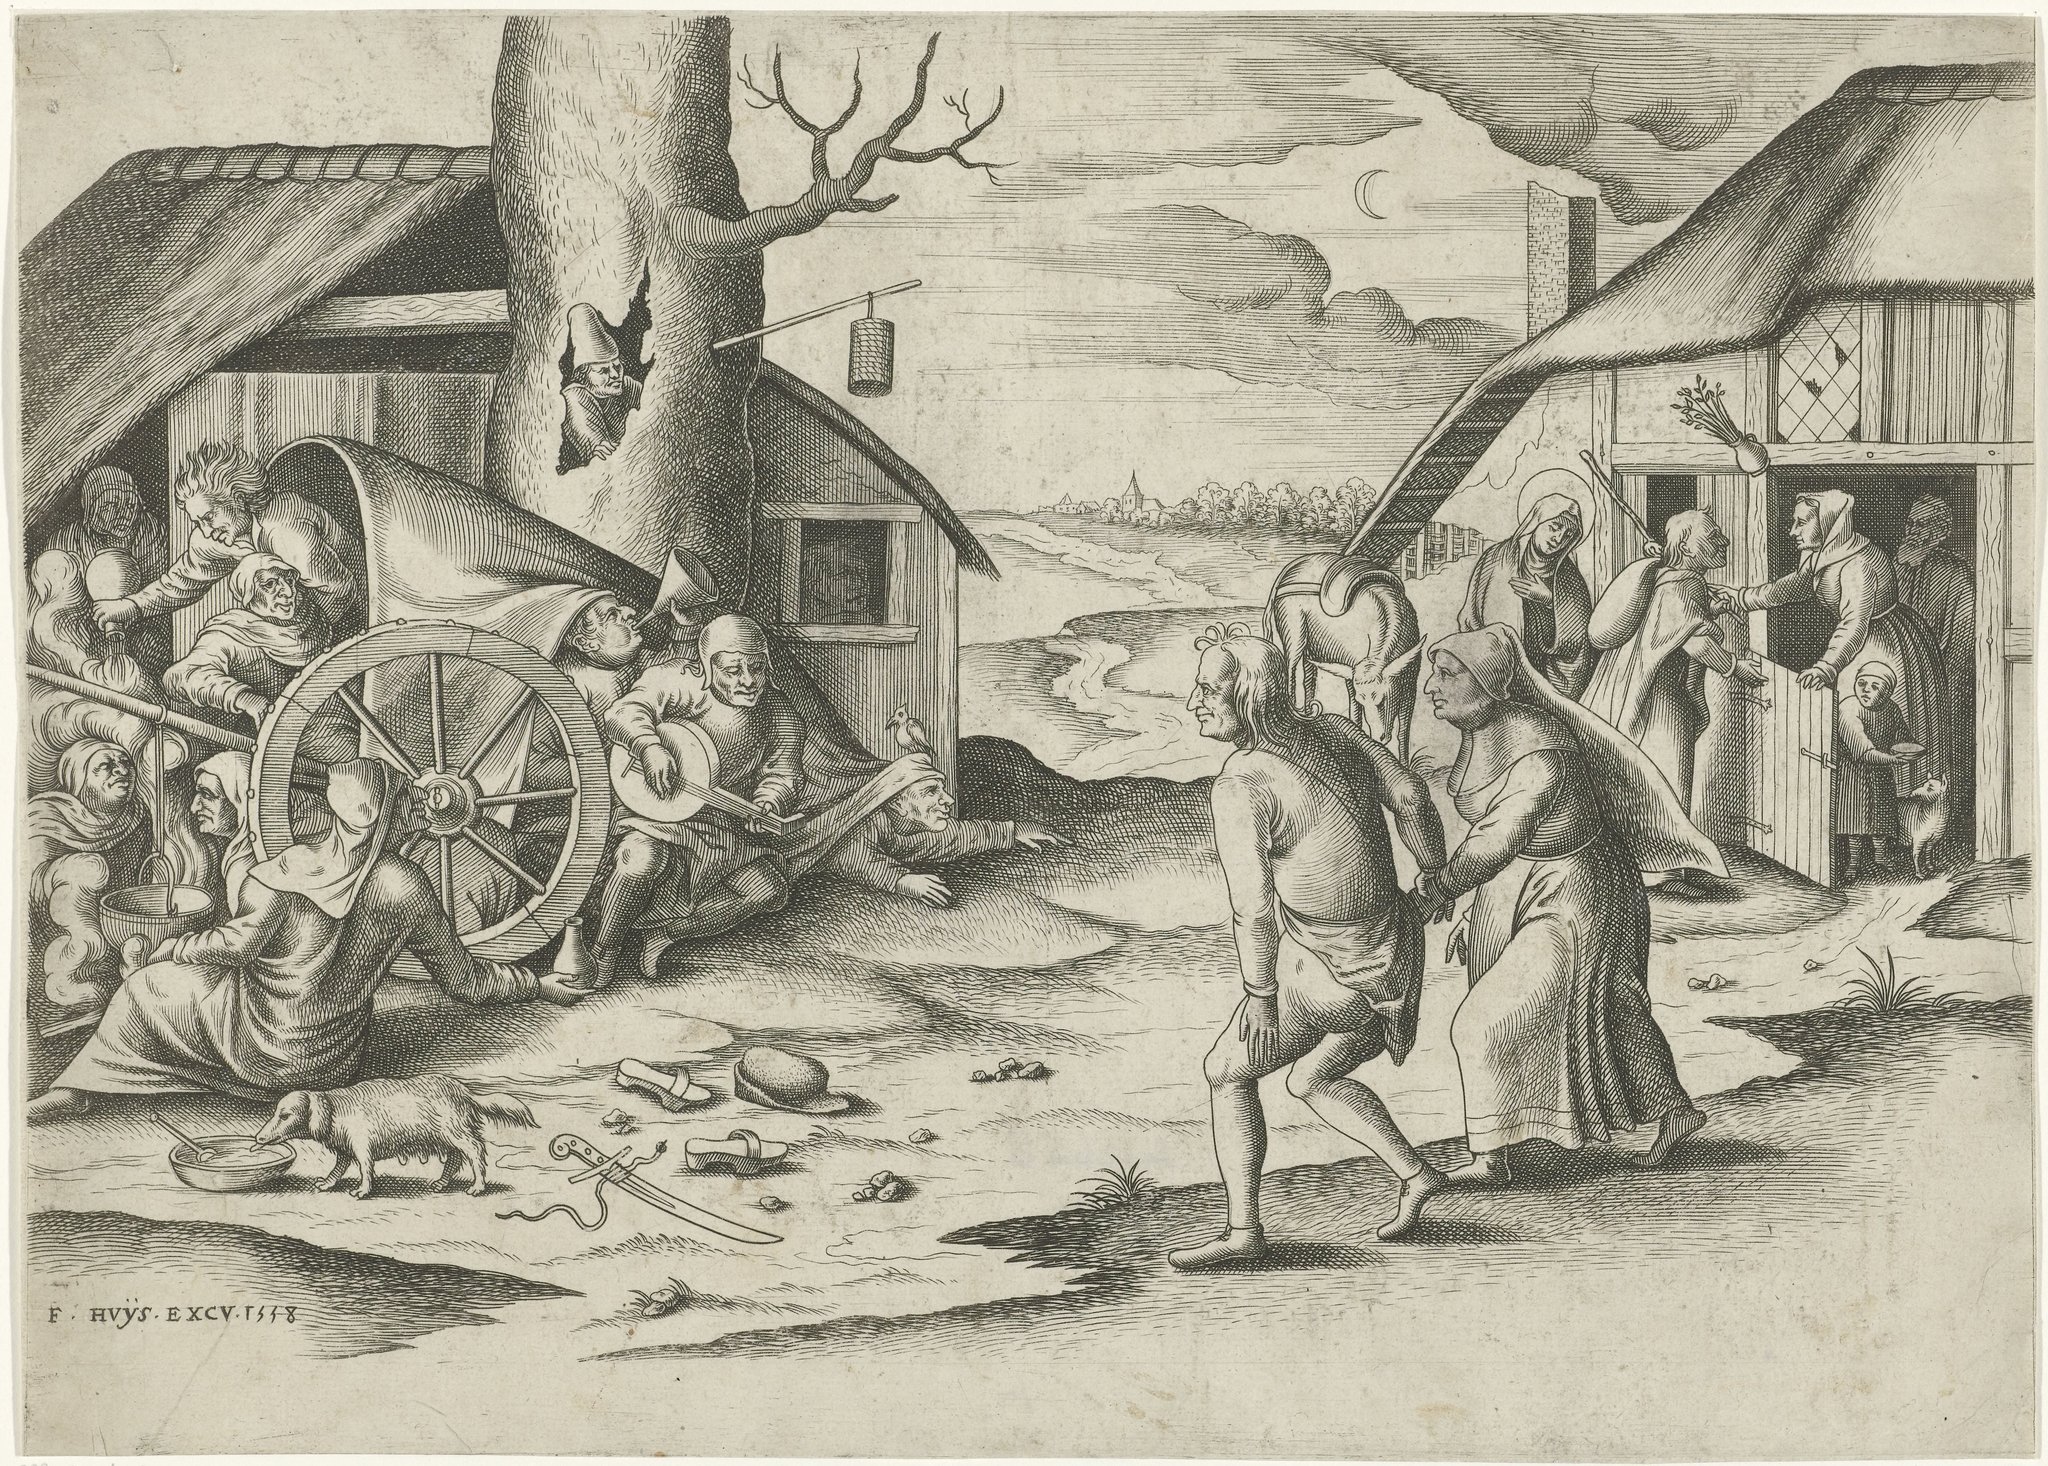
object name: print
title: Maria en Jozef bij een herberg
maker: frans huys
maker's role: print maker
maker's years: 1522-1562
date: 1558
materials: paper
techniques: engraving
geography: antwerp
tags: farmers, mary and joseph are not admitted to the inn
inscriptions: collector's mark: Lugt 2228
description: Jozef en Maria met de ezel, staand bij de herberg waar geen plaats voor hen is. In de deuropening staat een wijzende vrouw en een man, kind en hond. Links bij een boom een aantal figuren in een wagen voor een woning. Enkele figuren zitten rond een ketel boven een vuur. In de holle boom zit een man. Op de achtergrond een landschap met een weg, een kerktoren en bomen aan de horizon.